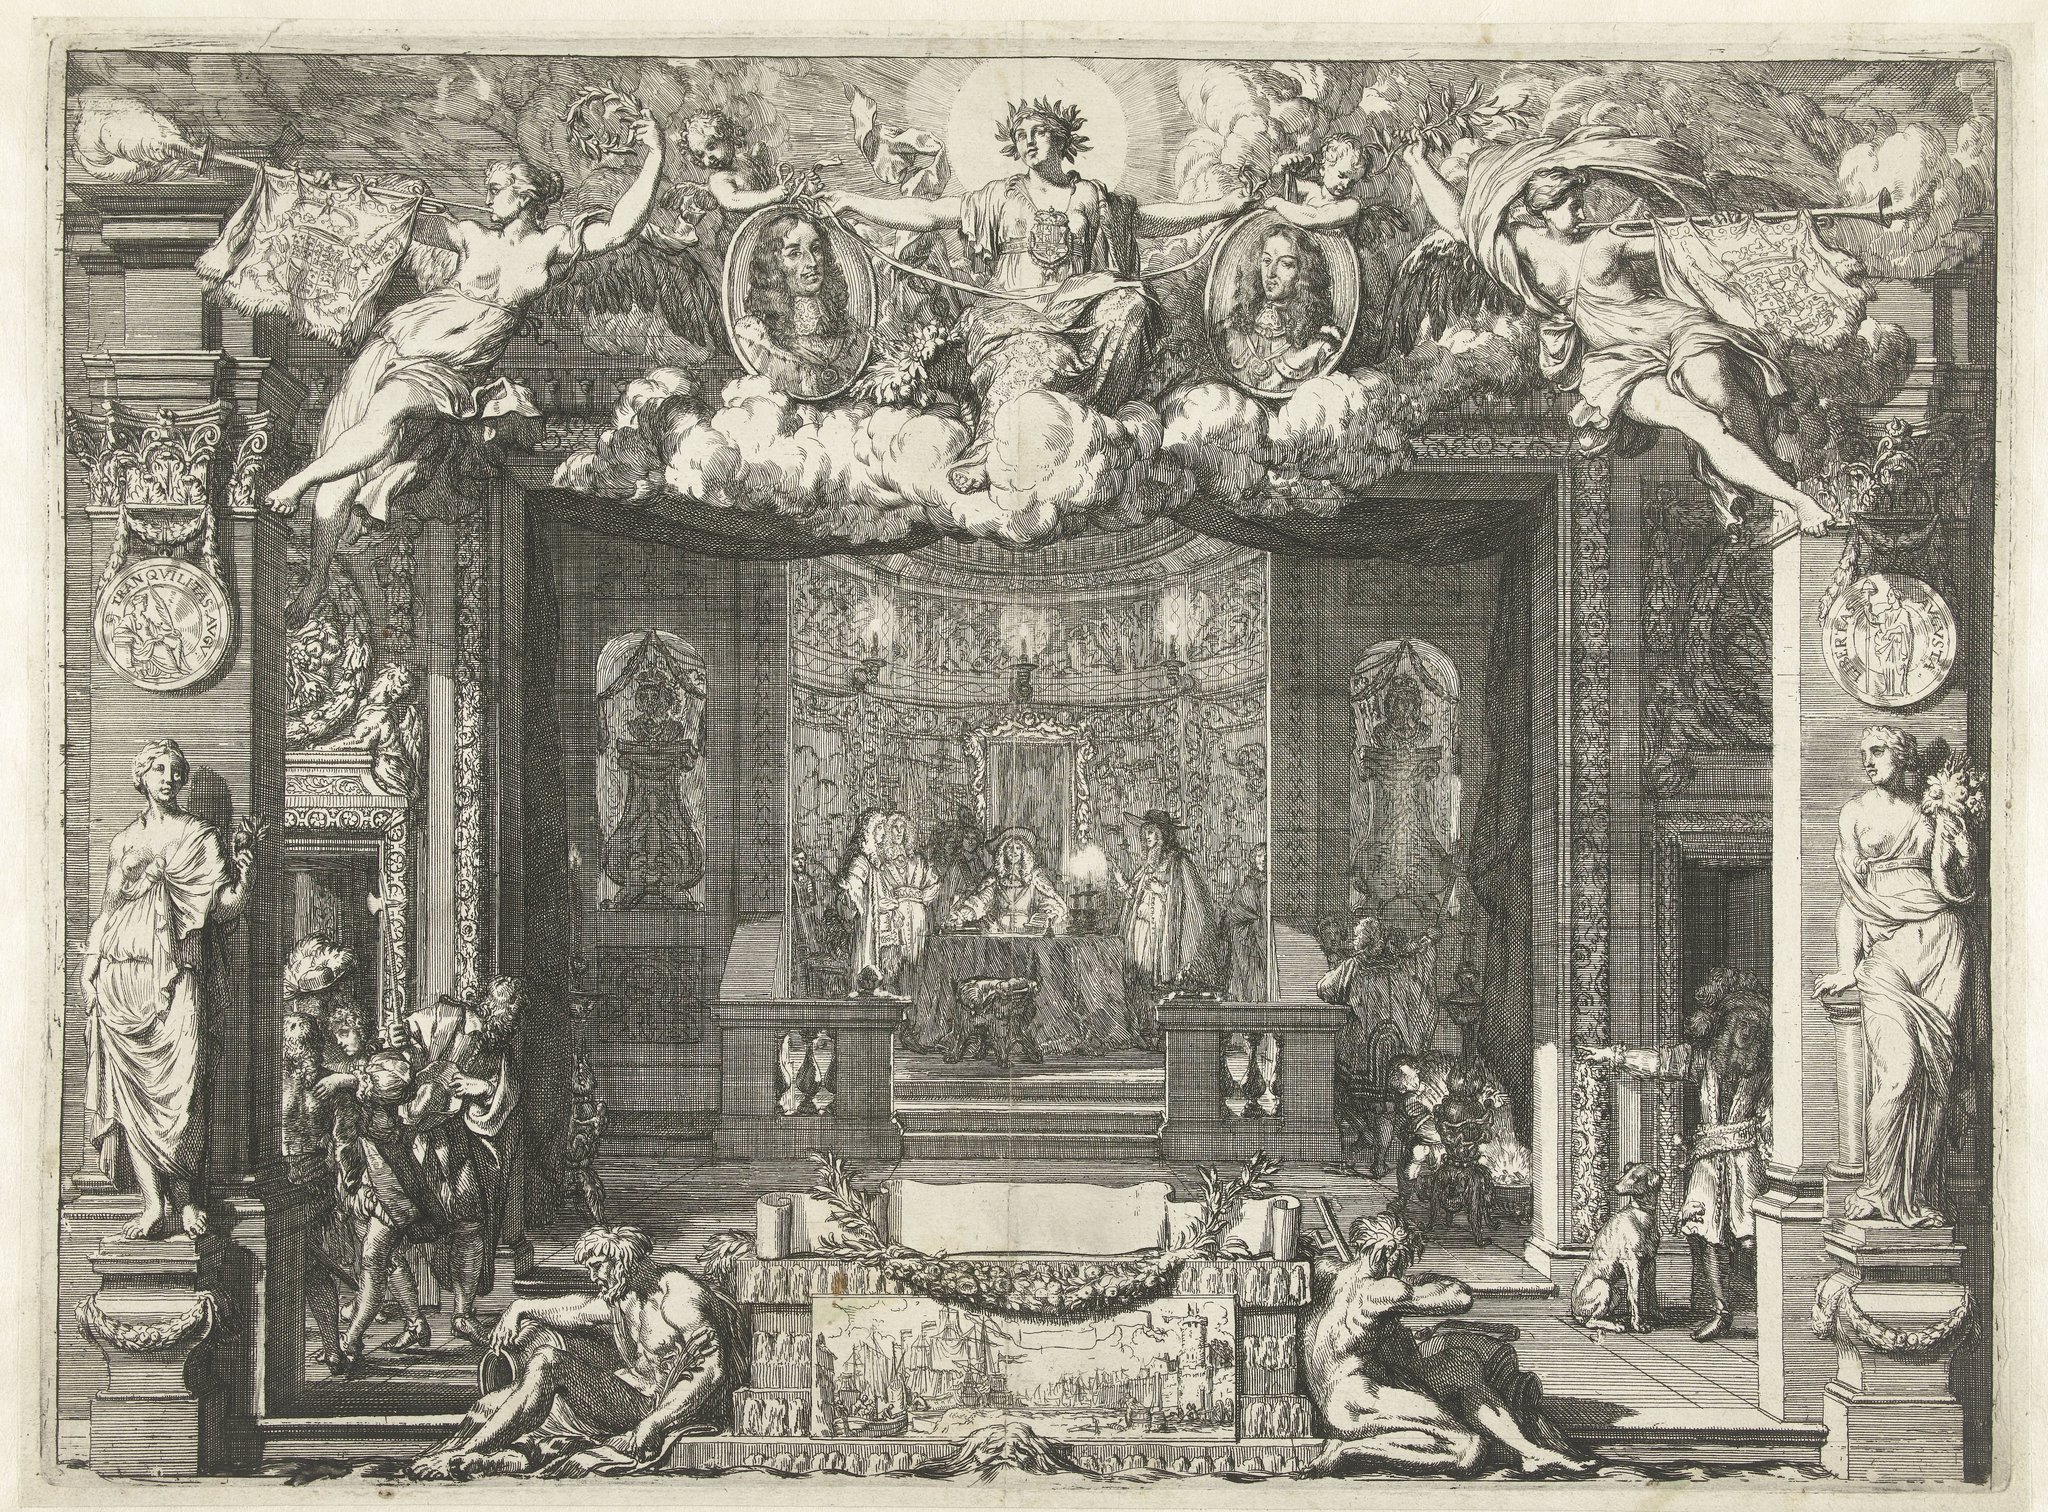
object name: print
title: Allegory of the Treaty of Westminster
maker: gerard de lairesse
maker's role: draughtsman, painter, print maker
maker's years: 1641-1711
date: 1674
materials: paper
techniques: etching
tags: william iii (prince of orange and king of england, scotland, and ireland), london, karel ii (koning van engeland), symbols, allegories of peace, 'pax'; 'pace' (ripa), fame; 'fama', 'fama buona', 'fama chiara' (ripa), signing of peace treaty, concluding the peace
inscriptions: collector's mark: Lugt 240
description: This depiction is in the form of a stage setting. De Lairesse was familiar with the world of the theatre: he designed various décors for the Amsterdam Theatre. Depicted in the middle is the signing of the Treaty of Westminster, above which are the portraits of King Charles II of England and Stadholder William III. This peace treaty signalled the end of the Third Anglo-Dutch War (1672-1674).